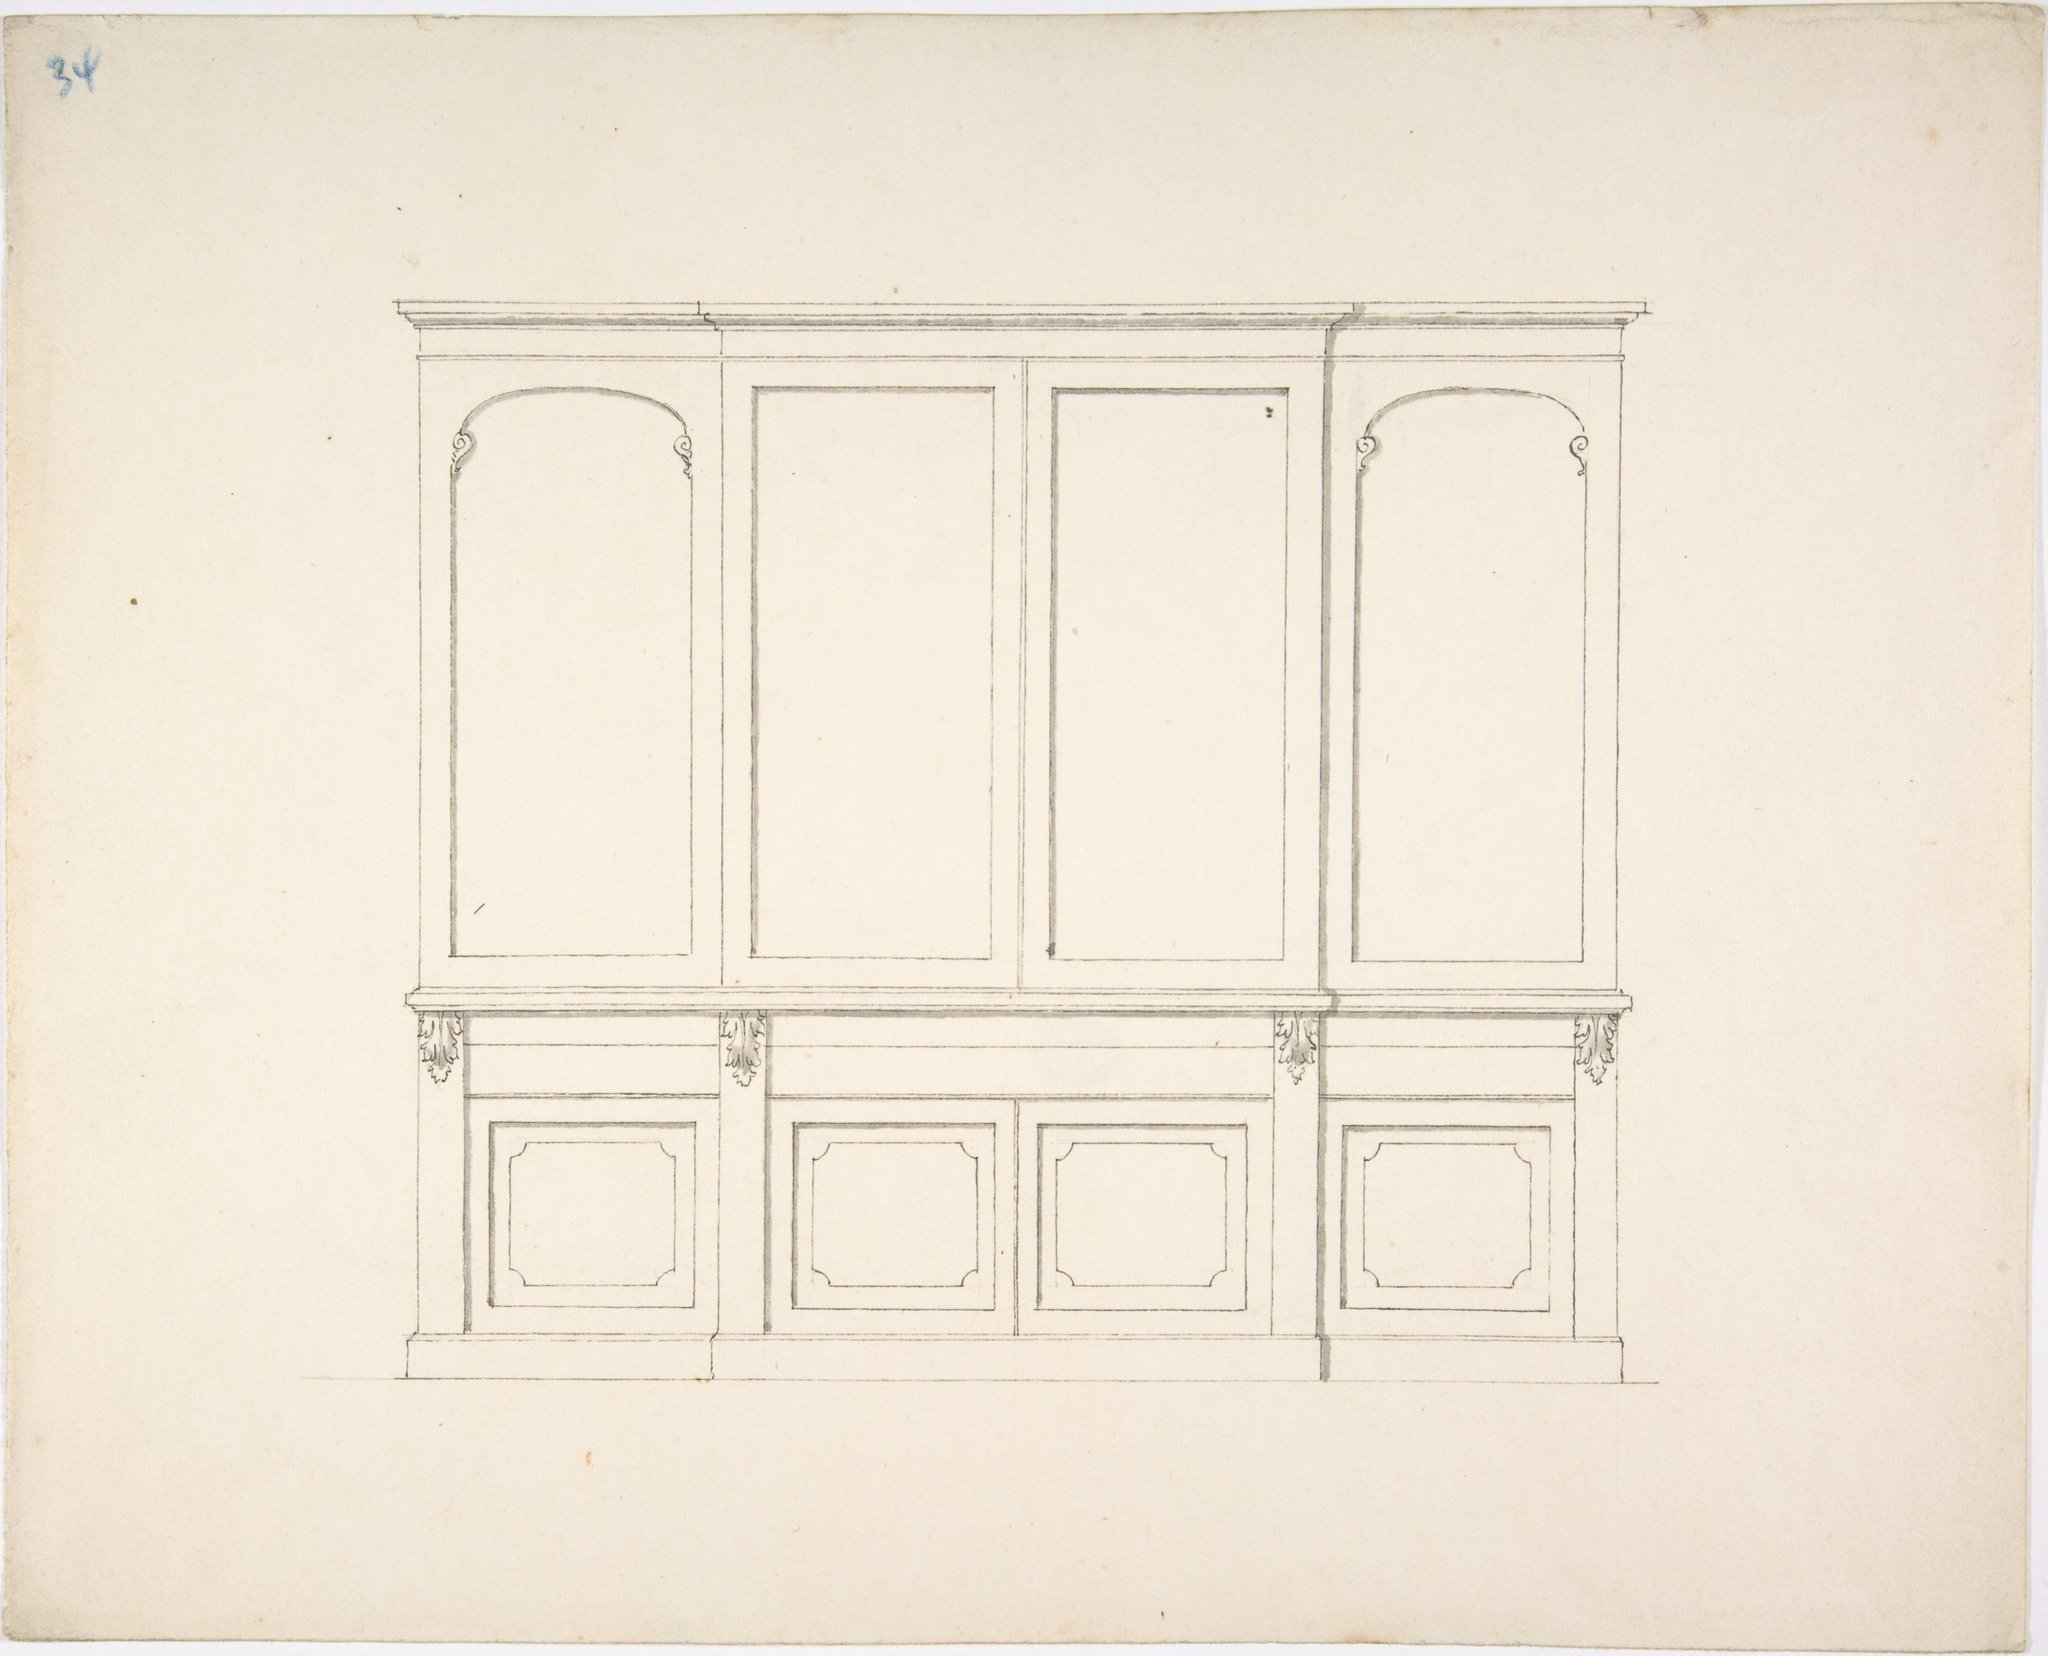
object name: drawing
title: Design for a Cabinet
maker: anonymous, british, 19th century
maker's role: artist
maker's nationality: british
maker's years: 1800-1900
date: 1801-1833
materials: ink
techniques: brush, pen, wash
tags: cabinets